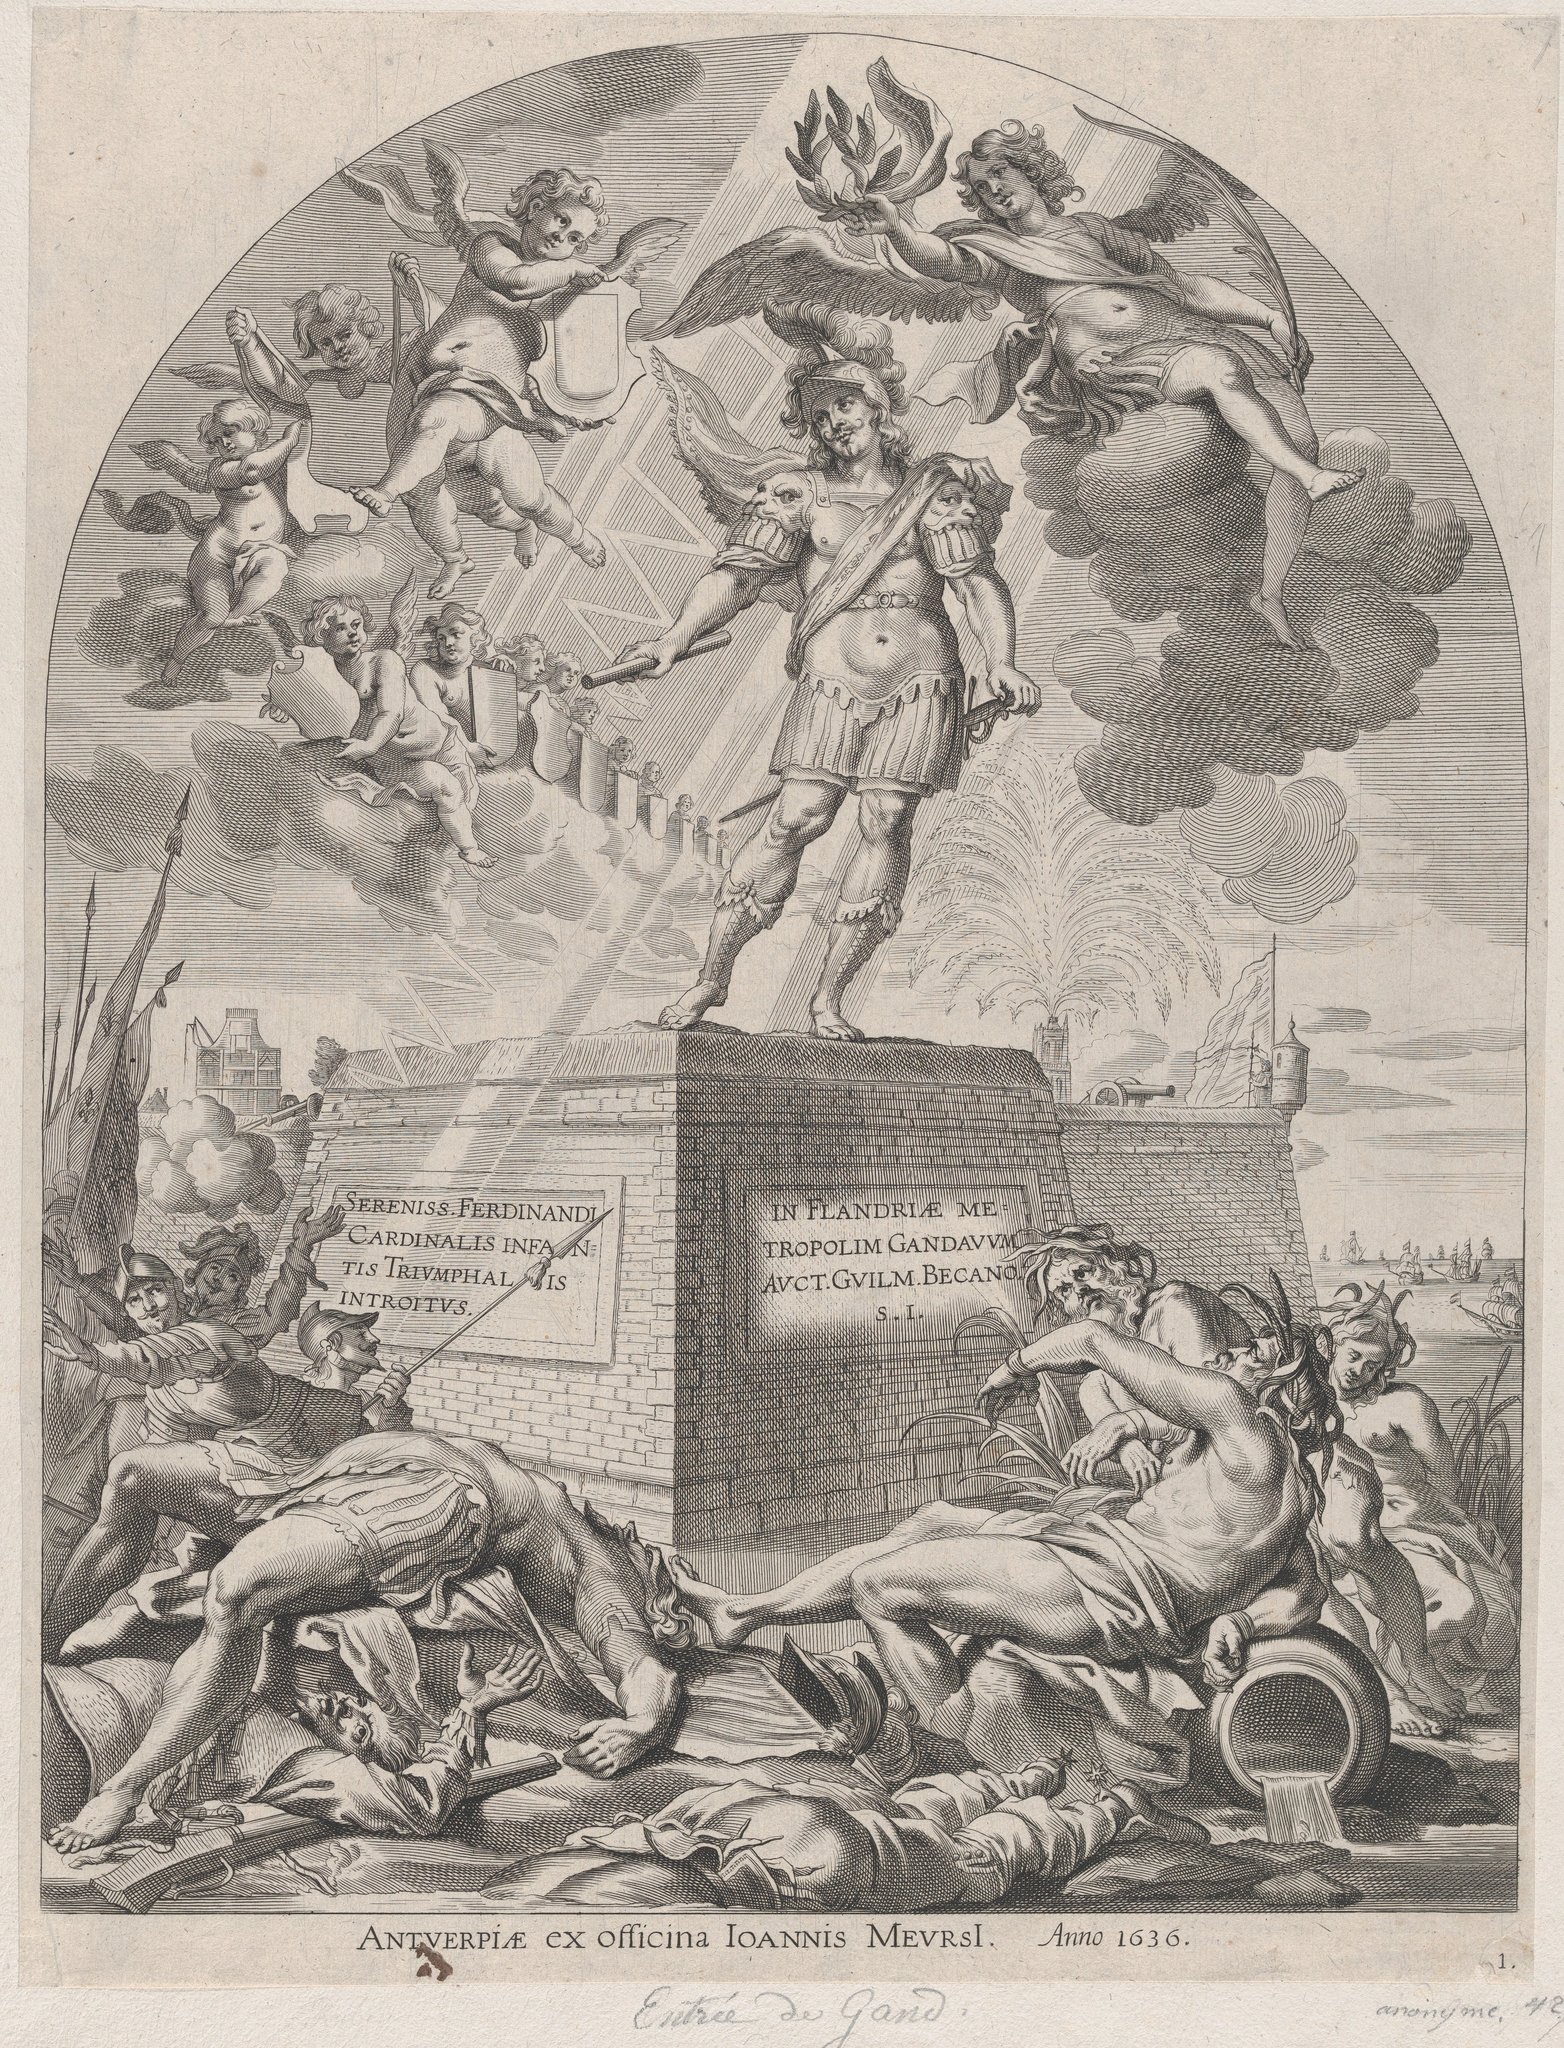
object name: print, fete, ornament architecture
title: Plate 1: Ferdinand as Mars, standing on a pedestal; from Guillielmus Becanus's 'Serenissimi Principis Ferdinandi, Hispaniarum Infantis...'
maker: pieter de jode (ii)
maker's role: artist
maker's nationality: flemish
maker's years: 1606-1674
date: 1636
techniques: engraving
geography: antwerp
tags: men,female nudes,mars